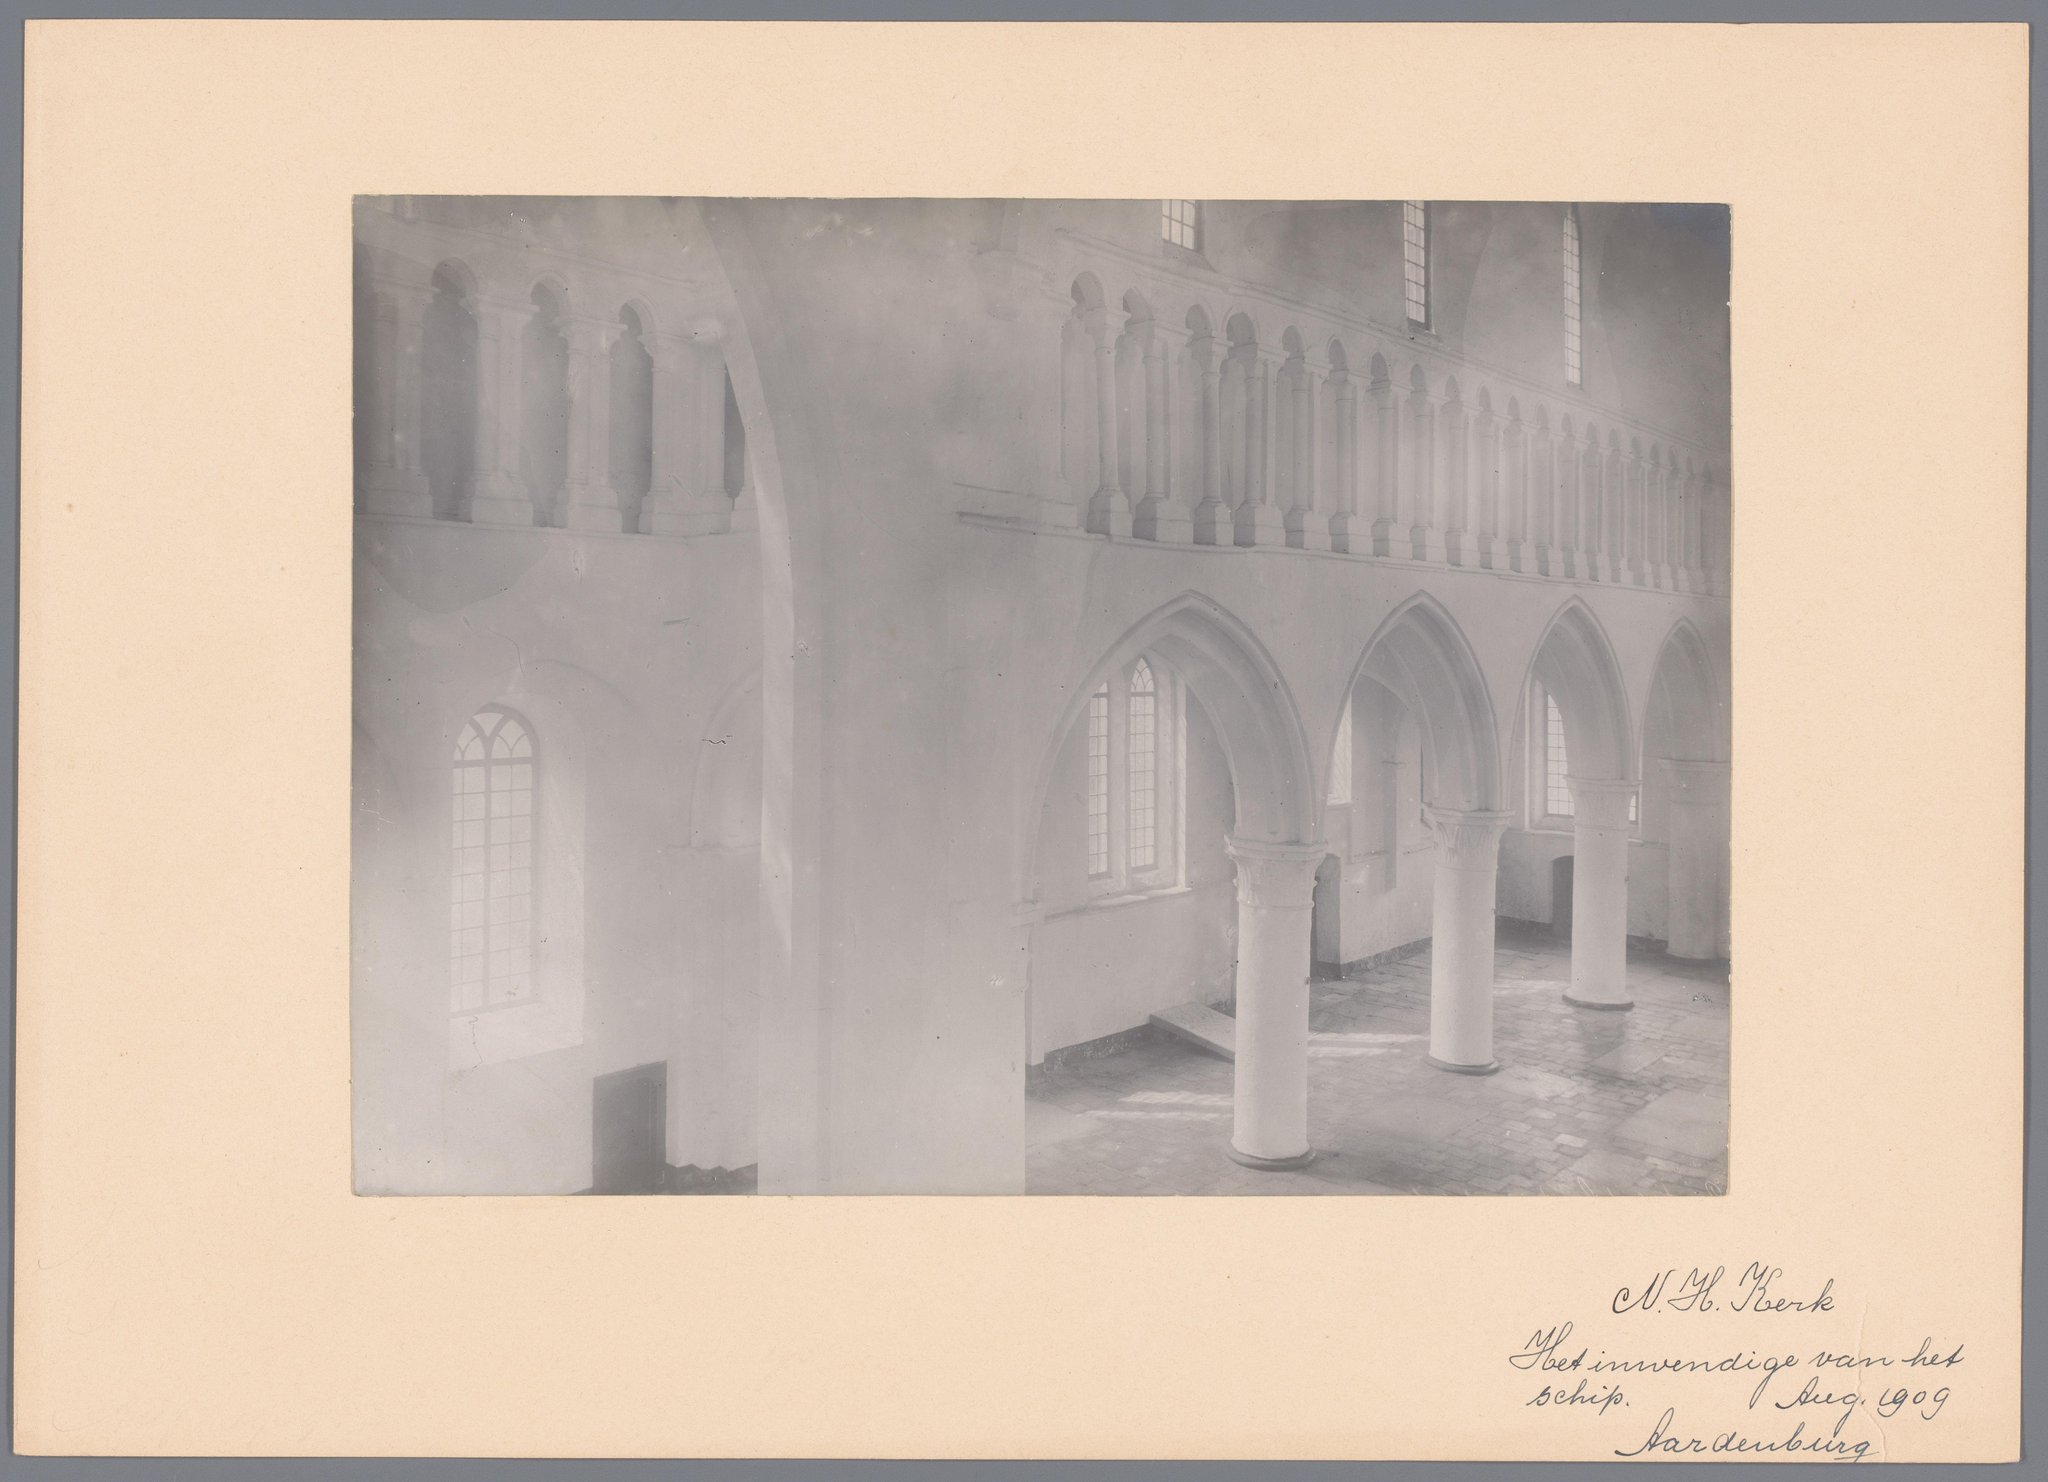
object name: photograph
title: Interieur van de Sint-Bavokerk te Aardenburg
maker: anoniem (monumentenzorg)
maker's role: fotograaf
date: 1909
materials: cardboard, photographic support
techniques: gelatin silver print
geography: aardenburg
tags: parts of church interior: nave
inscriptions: annotation: ‘N.H. Kerk/ Het inwendige van het schip/ Aug. 1909/ Aardenburg’